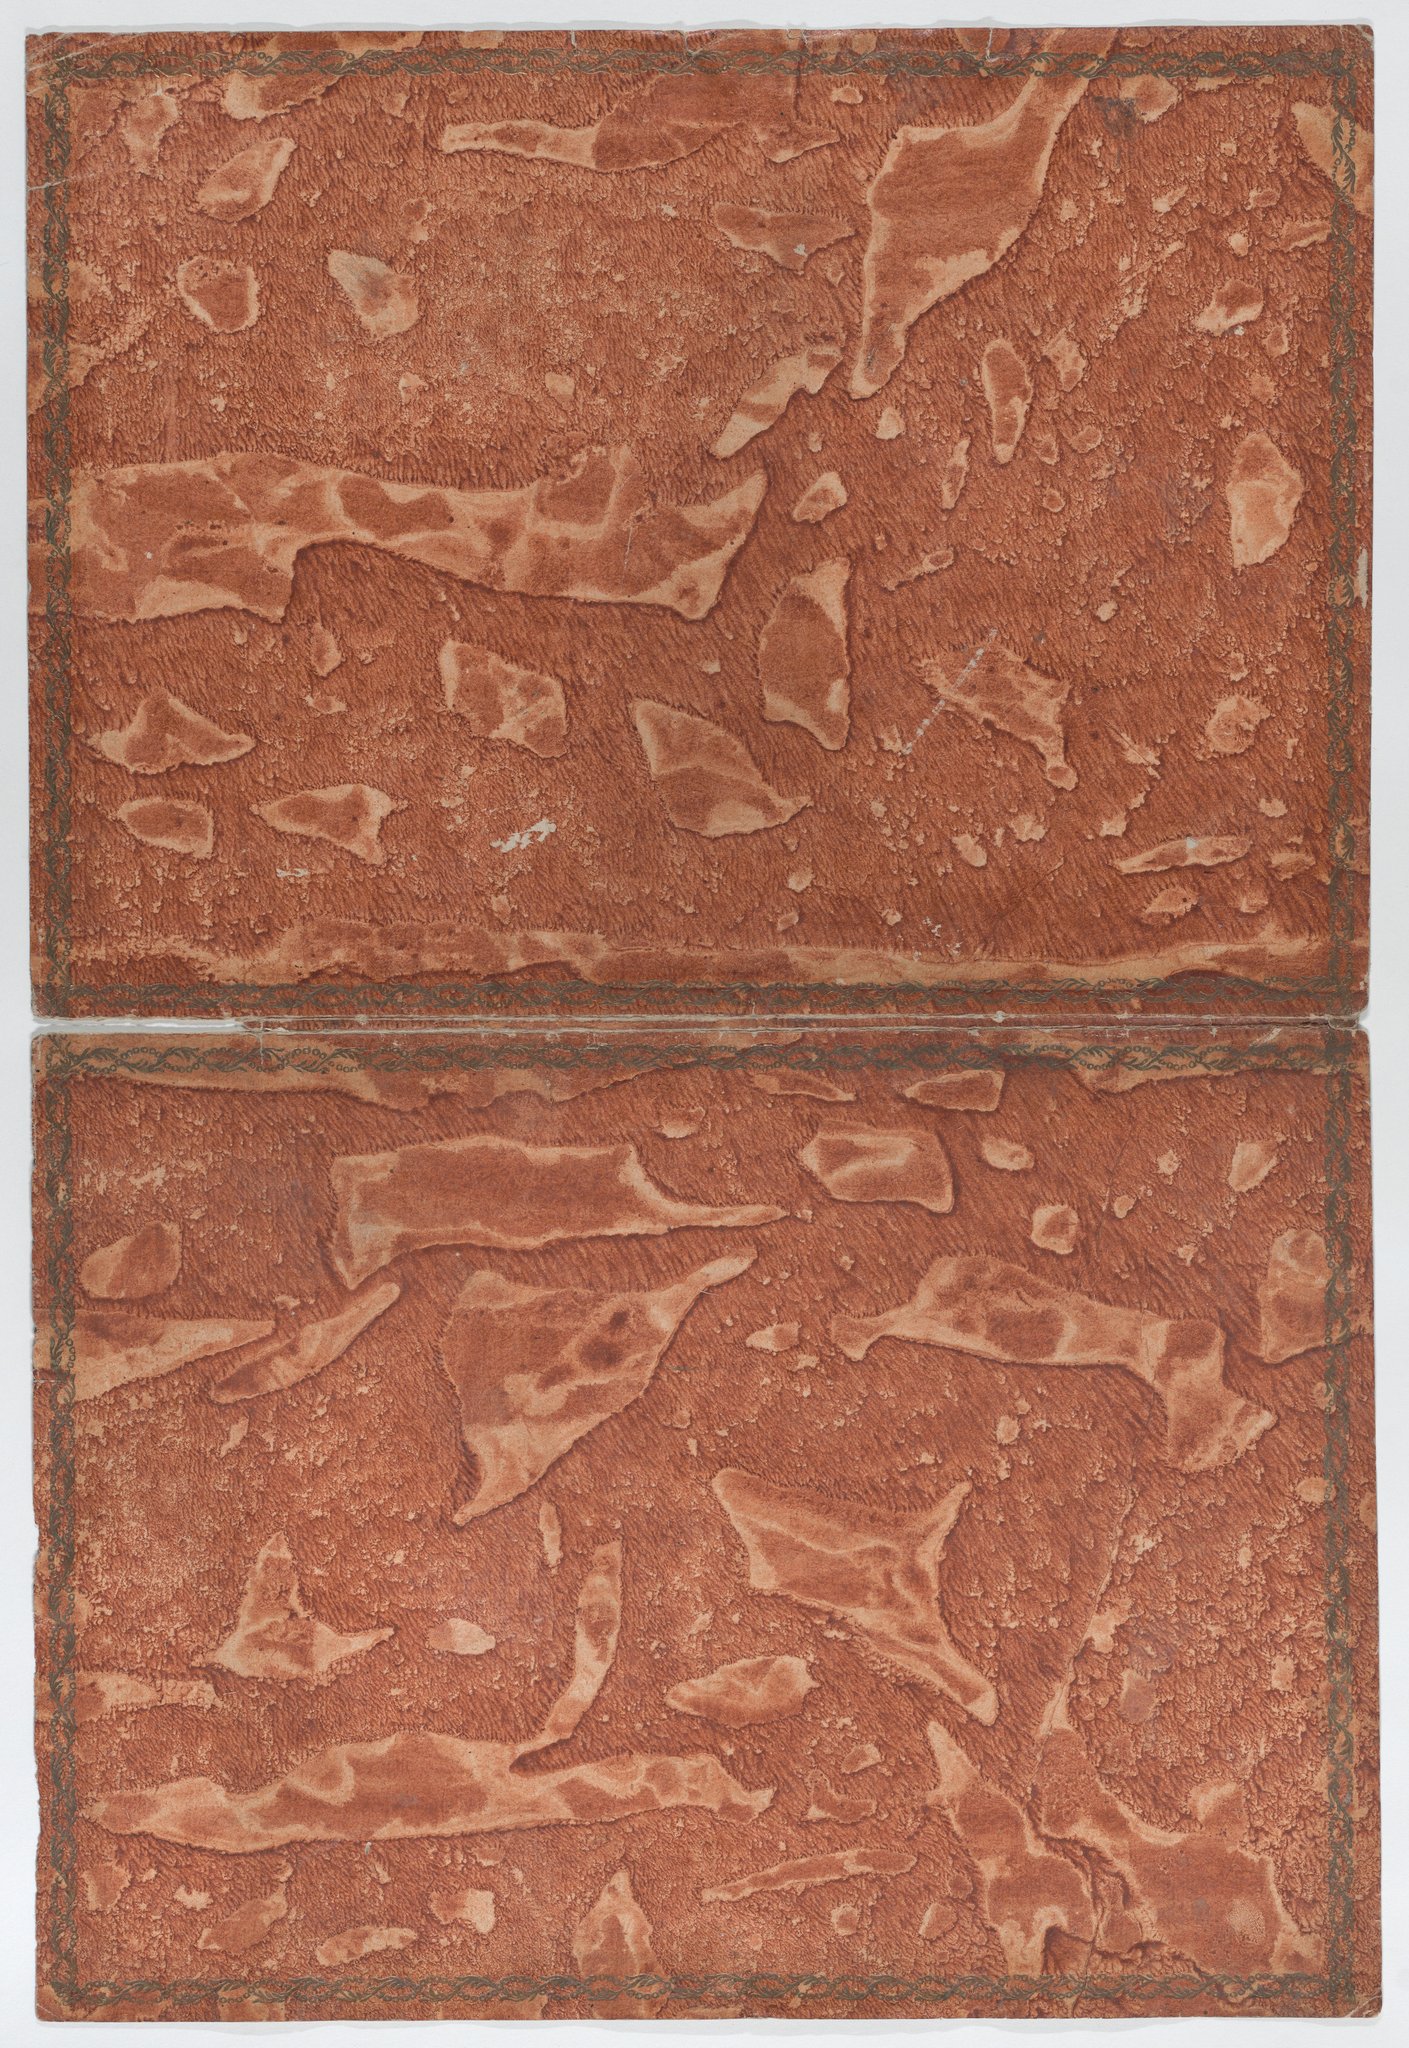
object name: print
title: Orange brown paste paper book cover with border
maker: Anonymous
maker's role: artist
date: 1701-1800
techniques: relief print